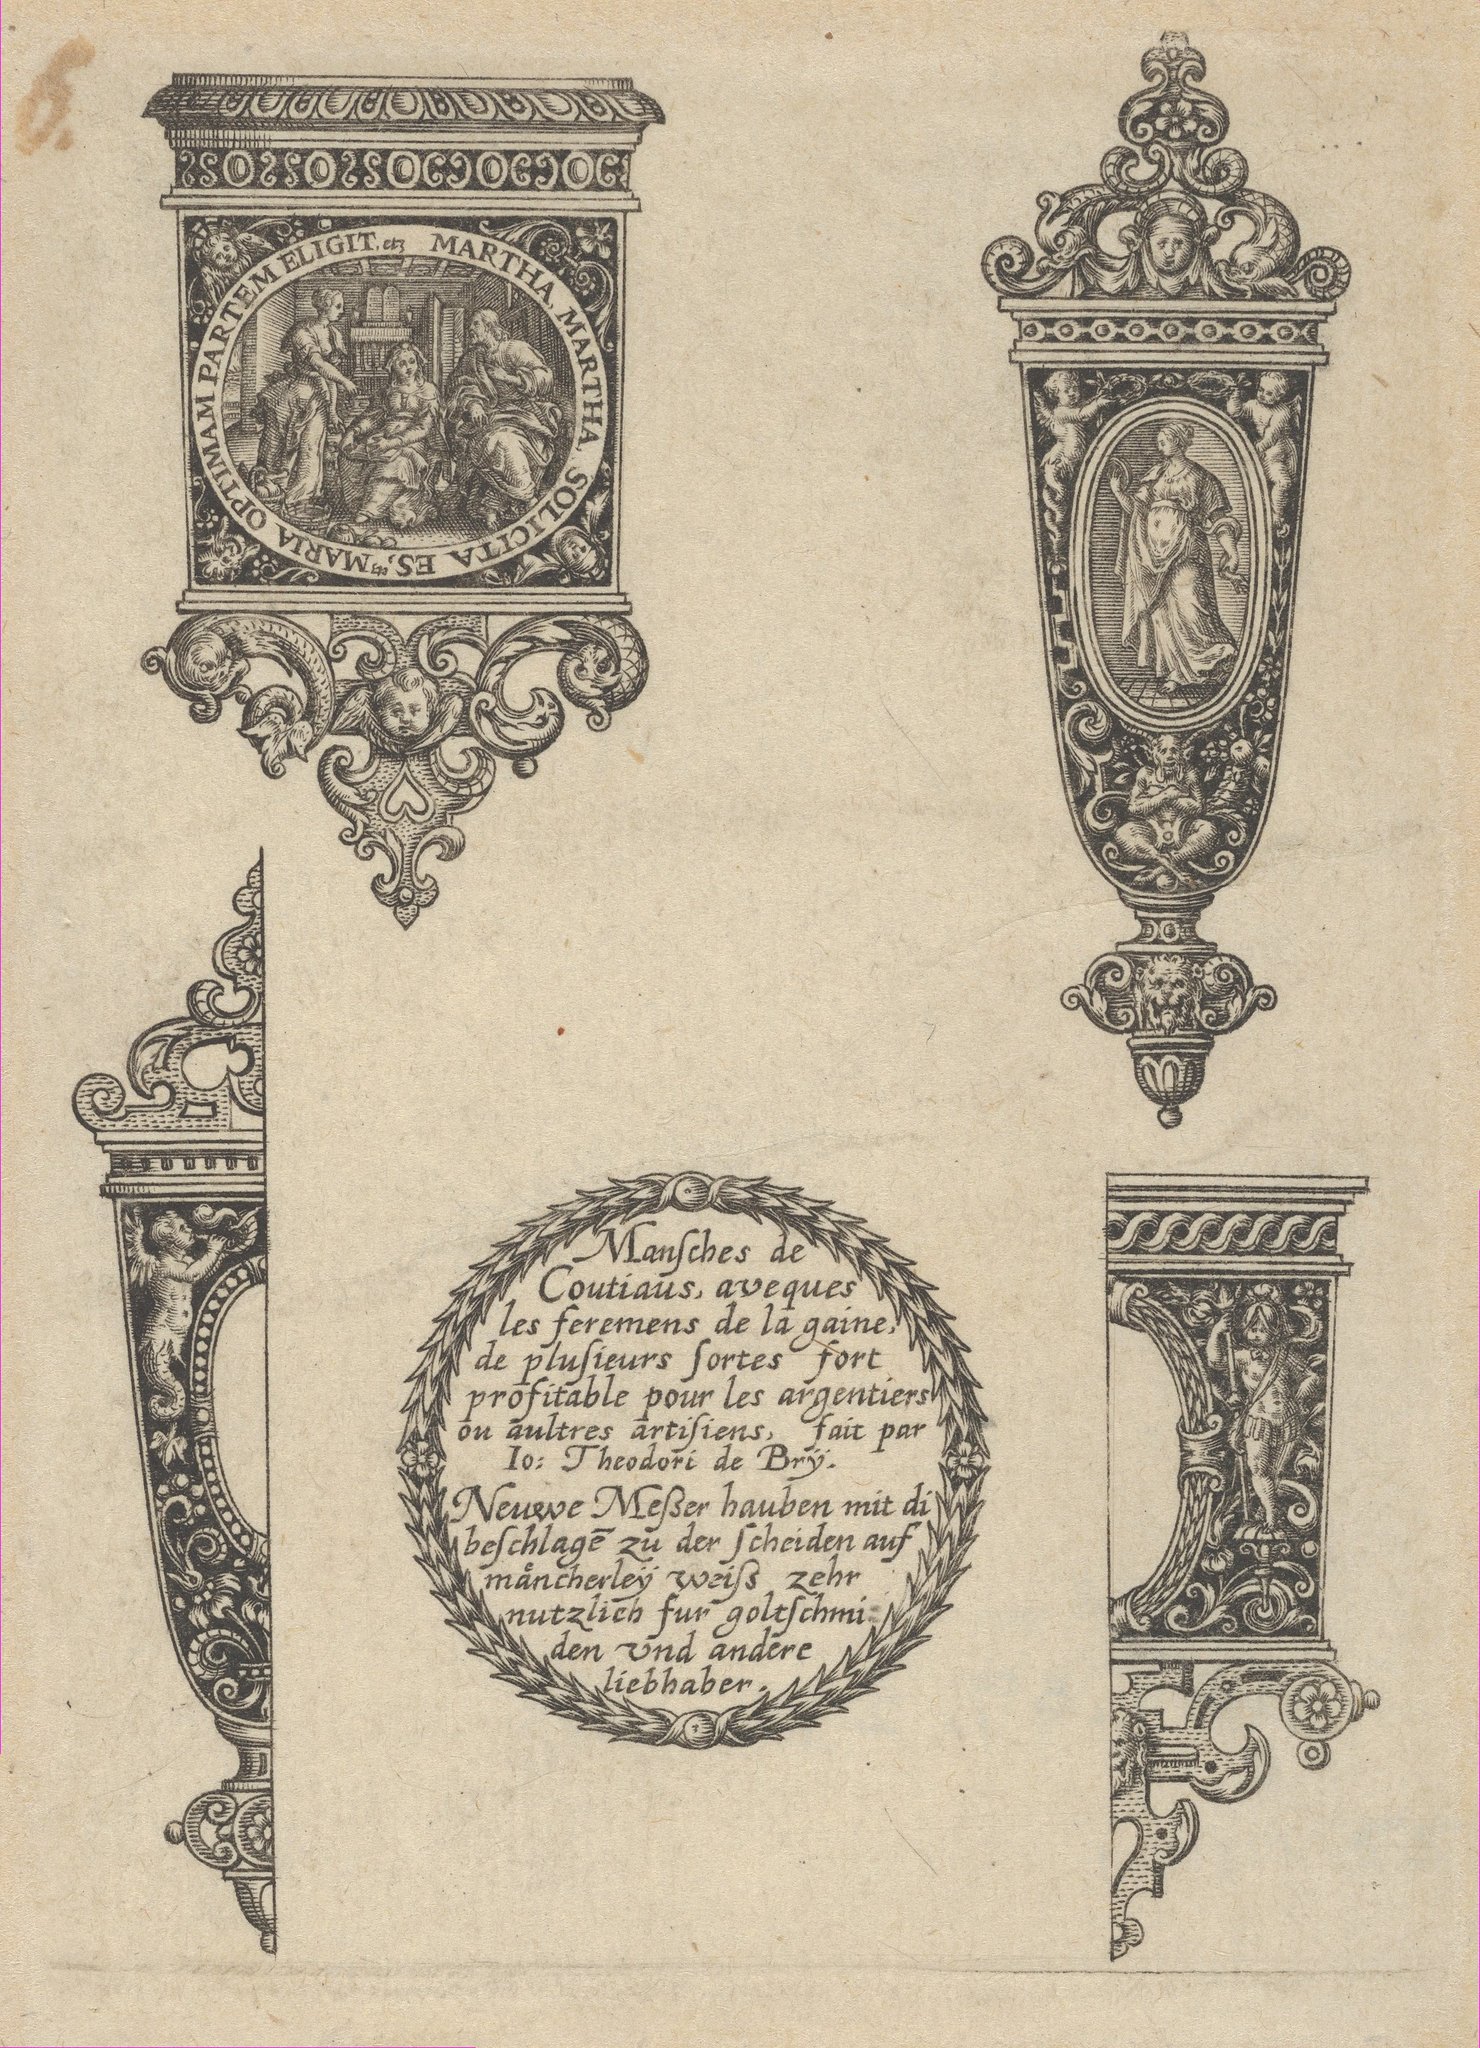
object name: print ornament architecture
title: Design for Four Knife Handles with Title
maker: johann theodor de bry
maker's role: artist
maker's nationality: netherlandish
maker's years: 1561-1623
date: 1580-1600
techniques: embroidery, engraving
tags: virgin mary,jesus